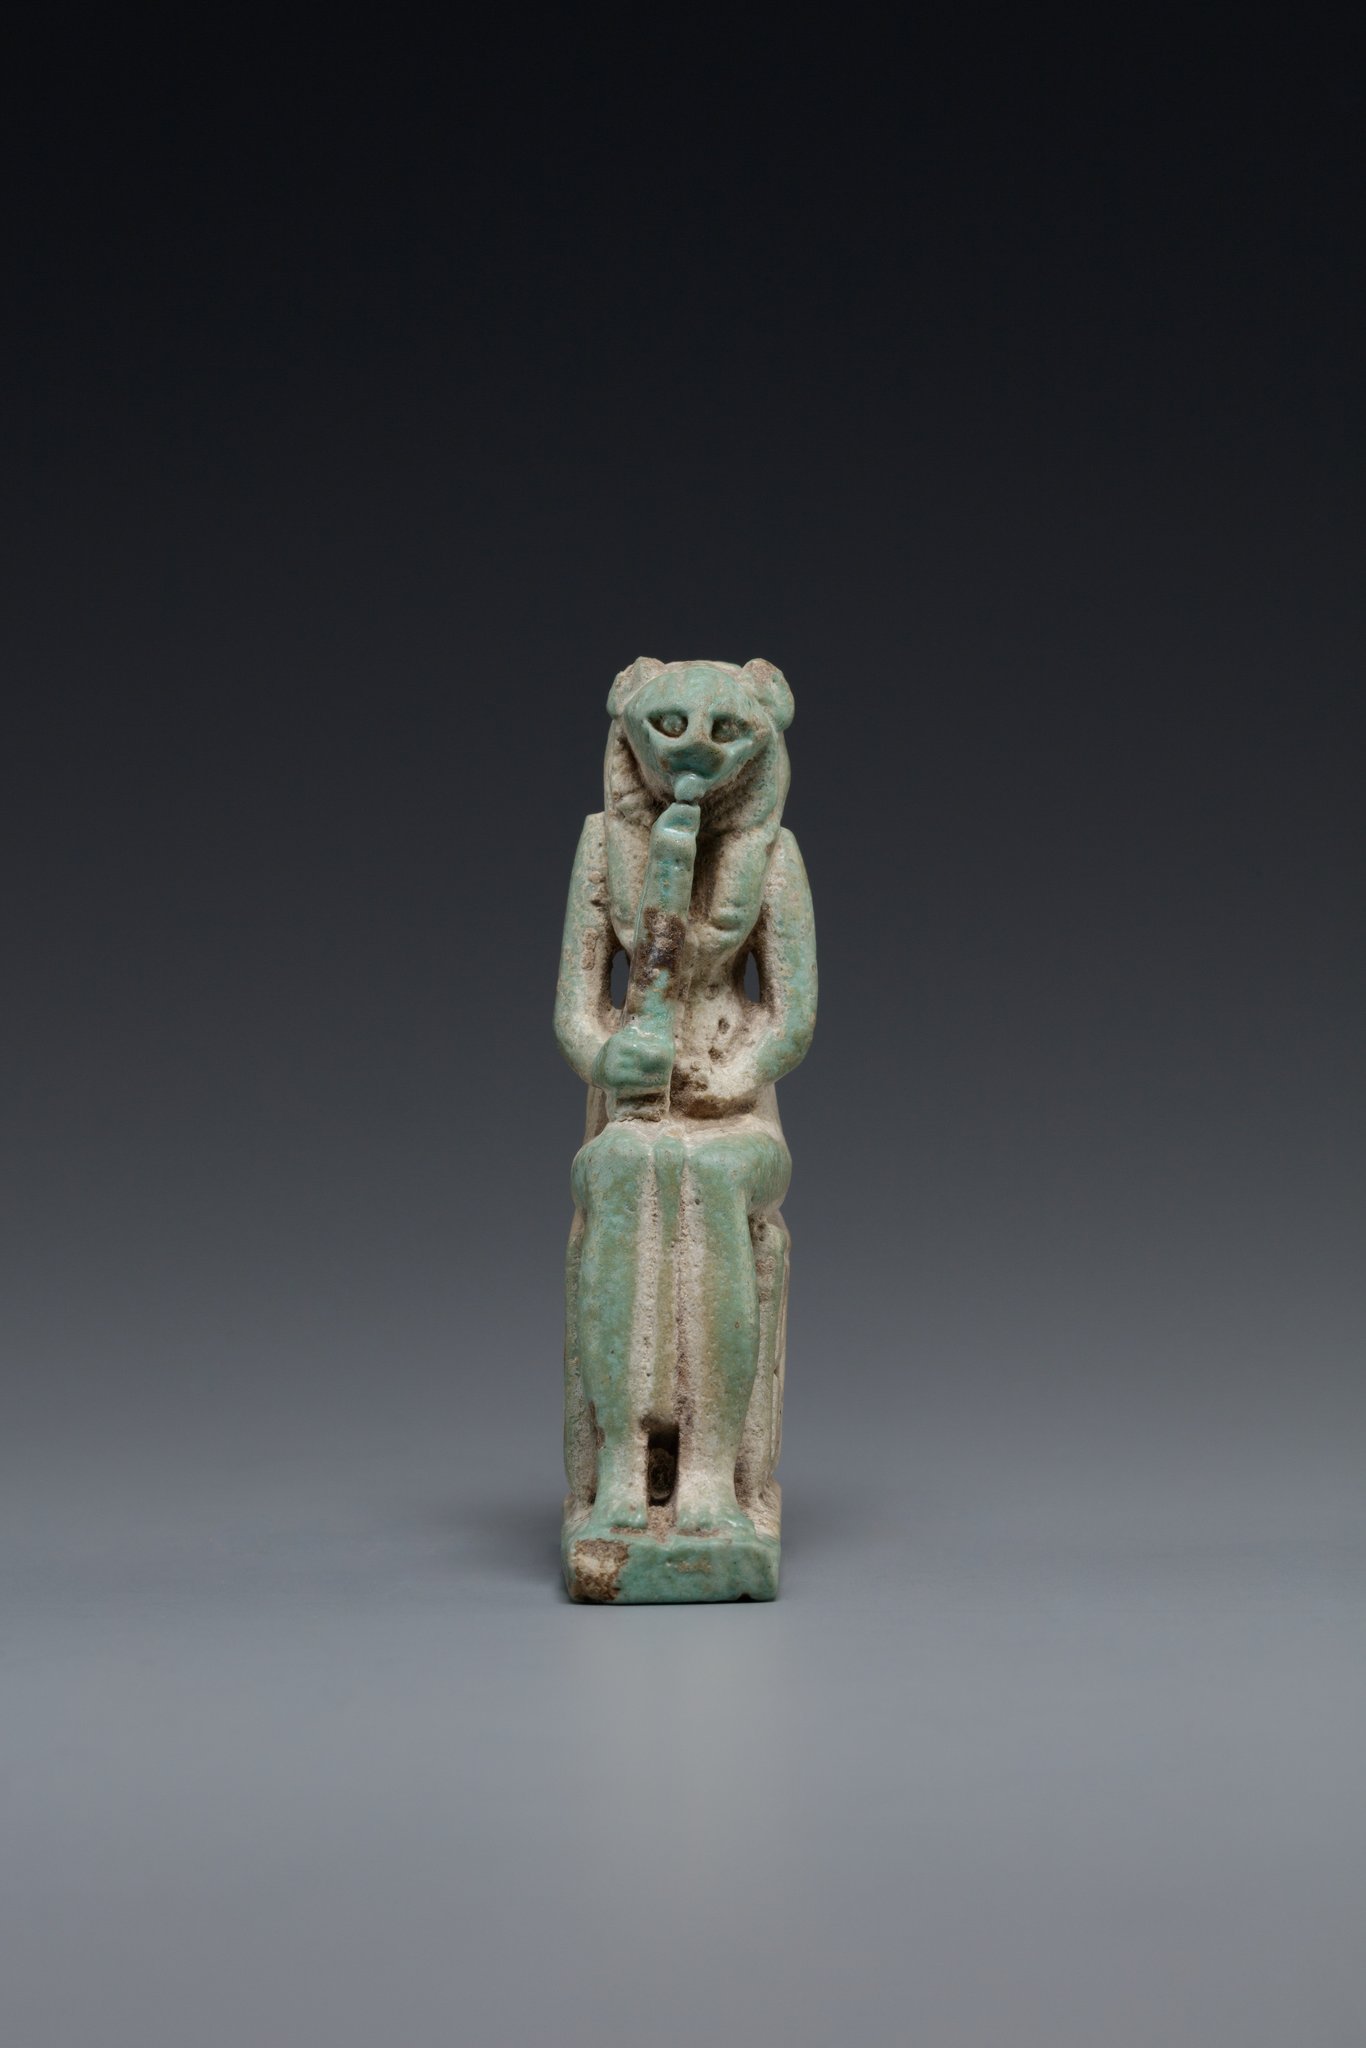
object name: amulet, bastet, sistrum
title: Bastet Amulet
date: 664-630 BCE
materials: faience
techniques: glazing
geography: egypt